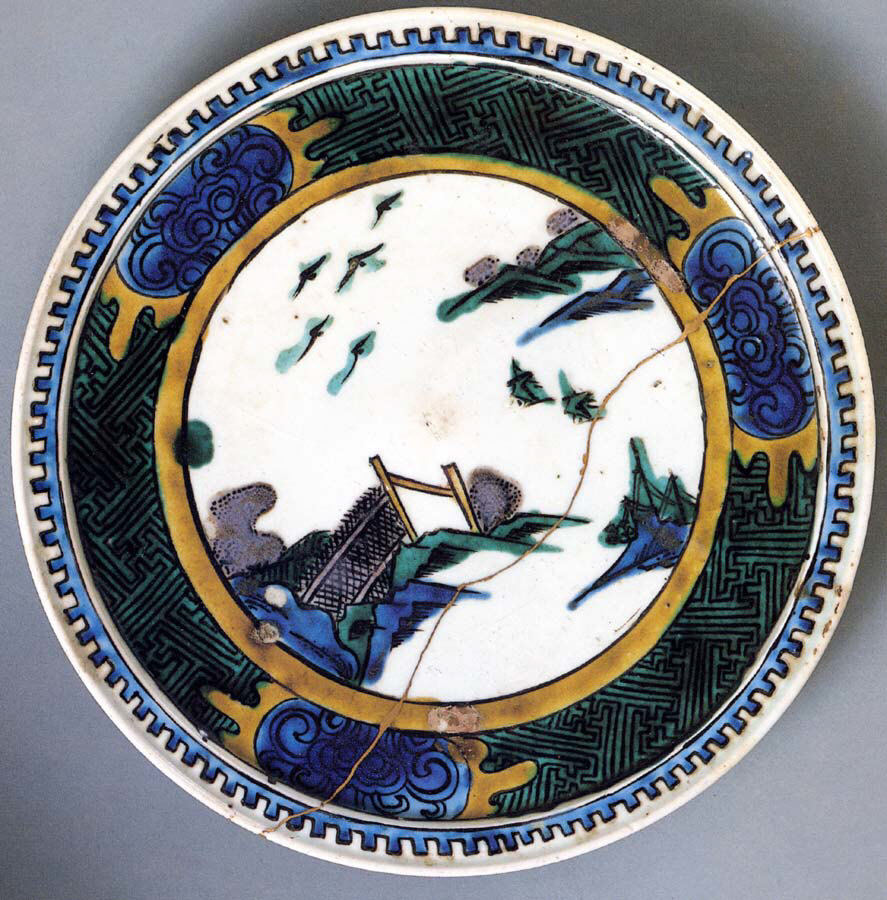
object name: plate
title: Plate with Landscape Decoration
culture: japanese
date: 1670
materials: enamel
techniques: overglaze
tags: birds,landscapes